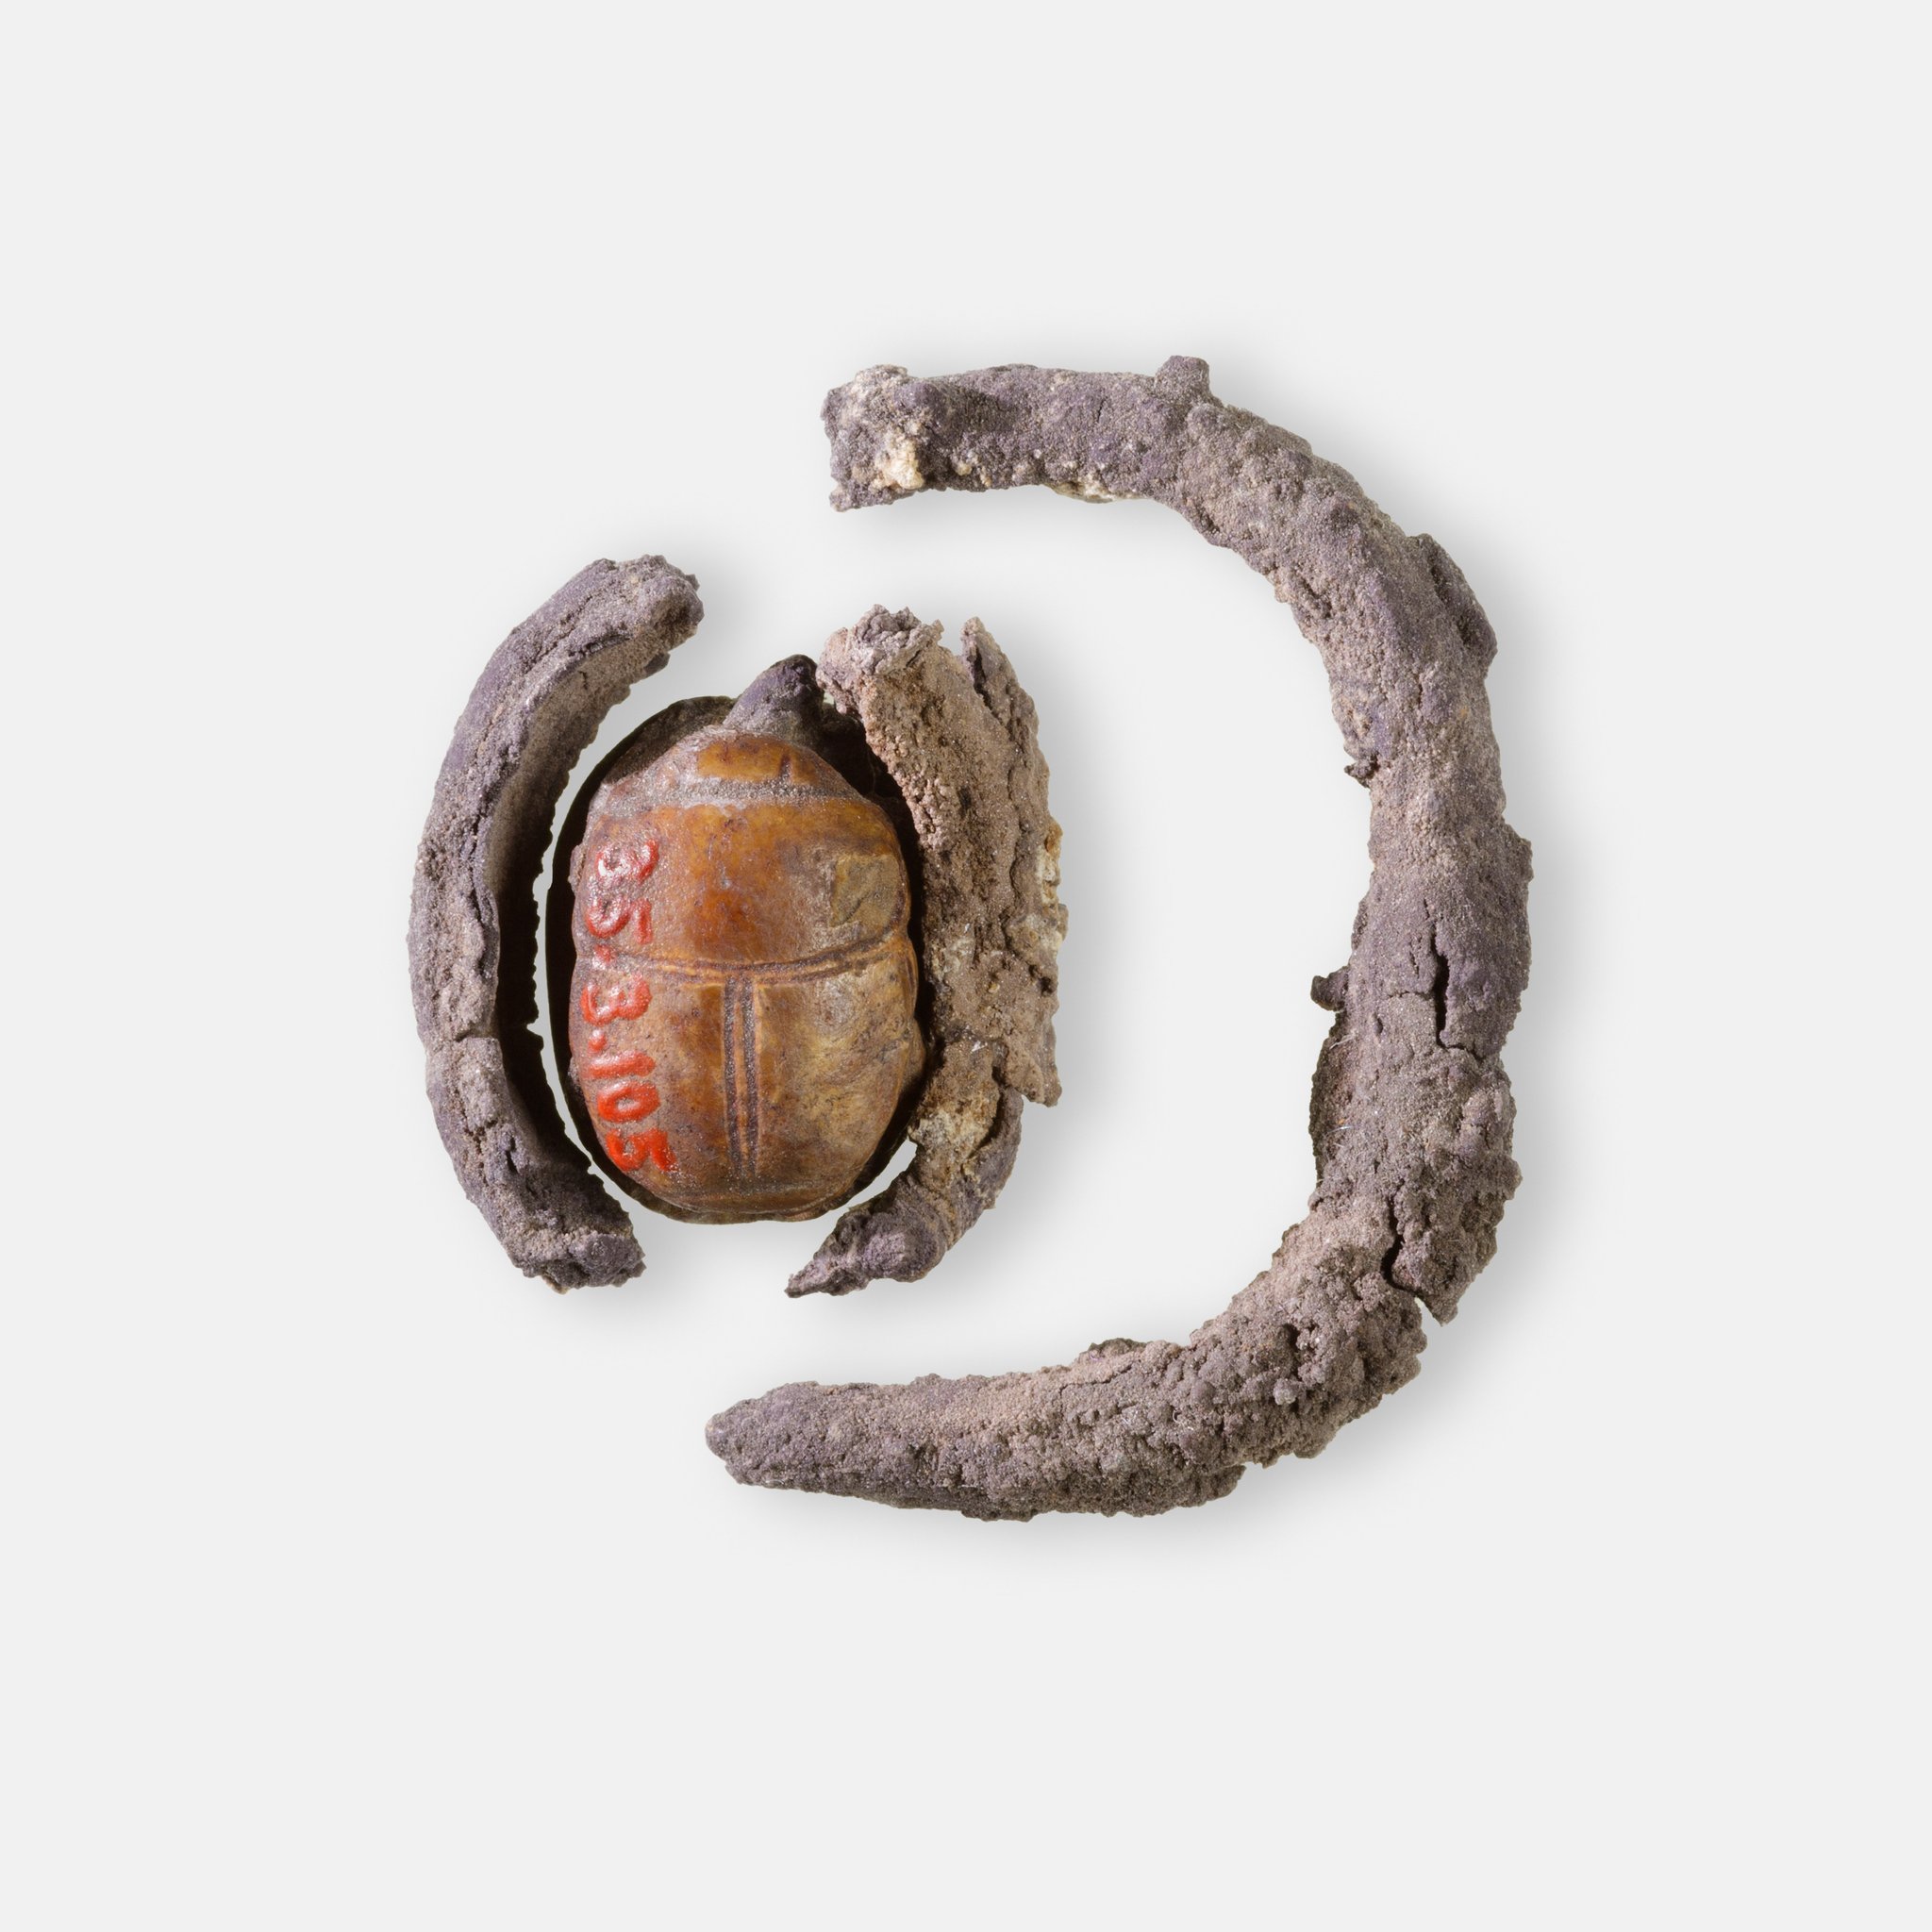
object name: ring, scarab, neferkhawet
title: Scarab Finger Ring of Neferkhawet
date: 1504-1447 BCE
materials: silver, stone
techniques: glazing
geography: egypt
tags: scarabs